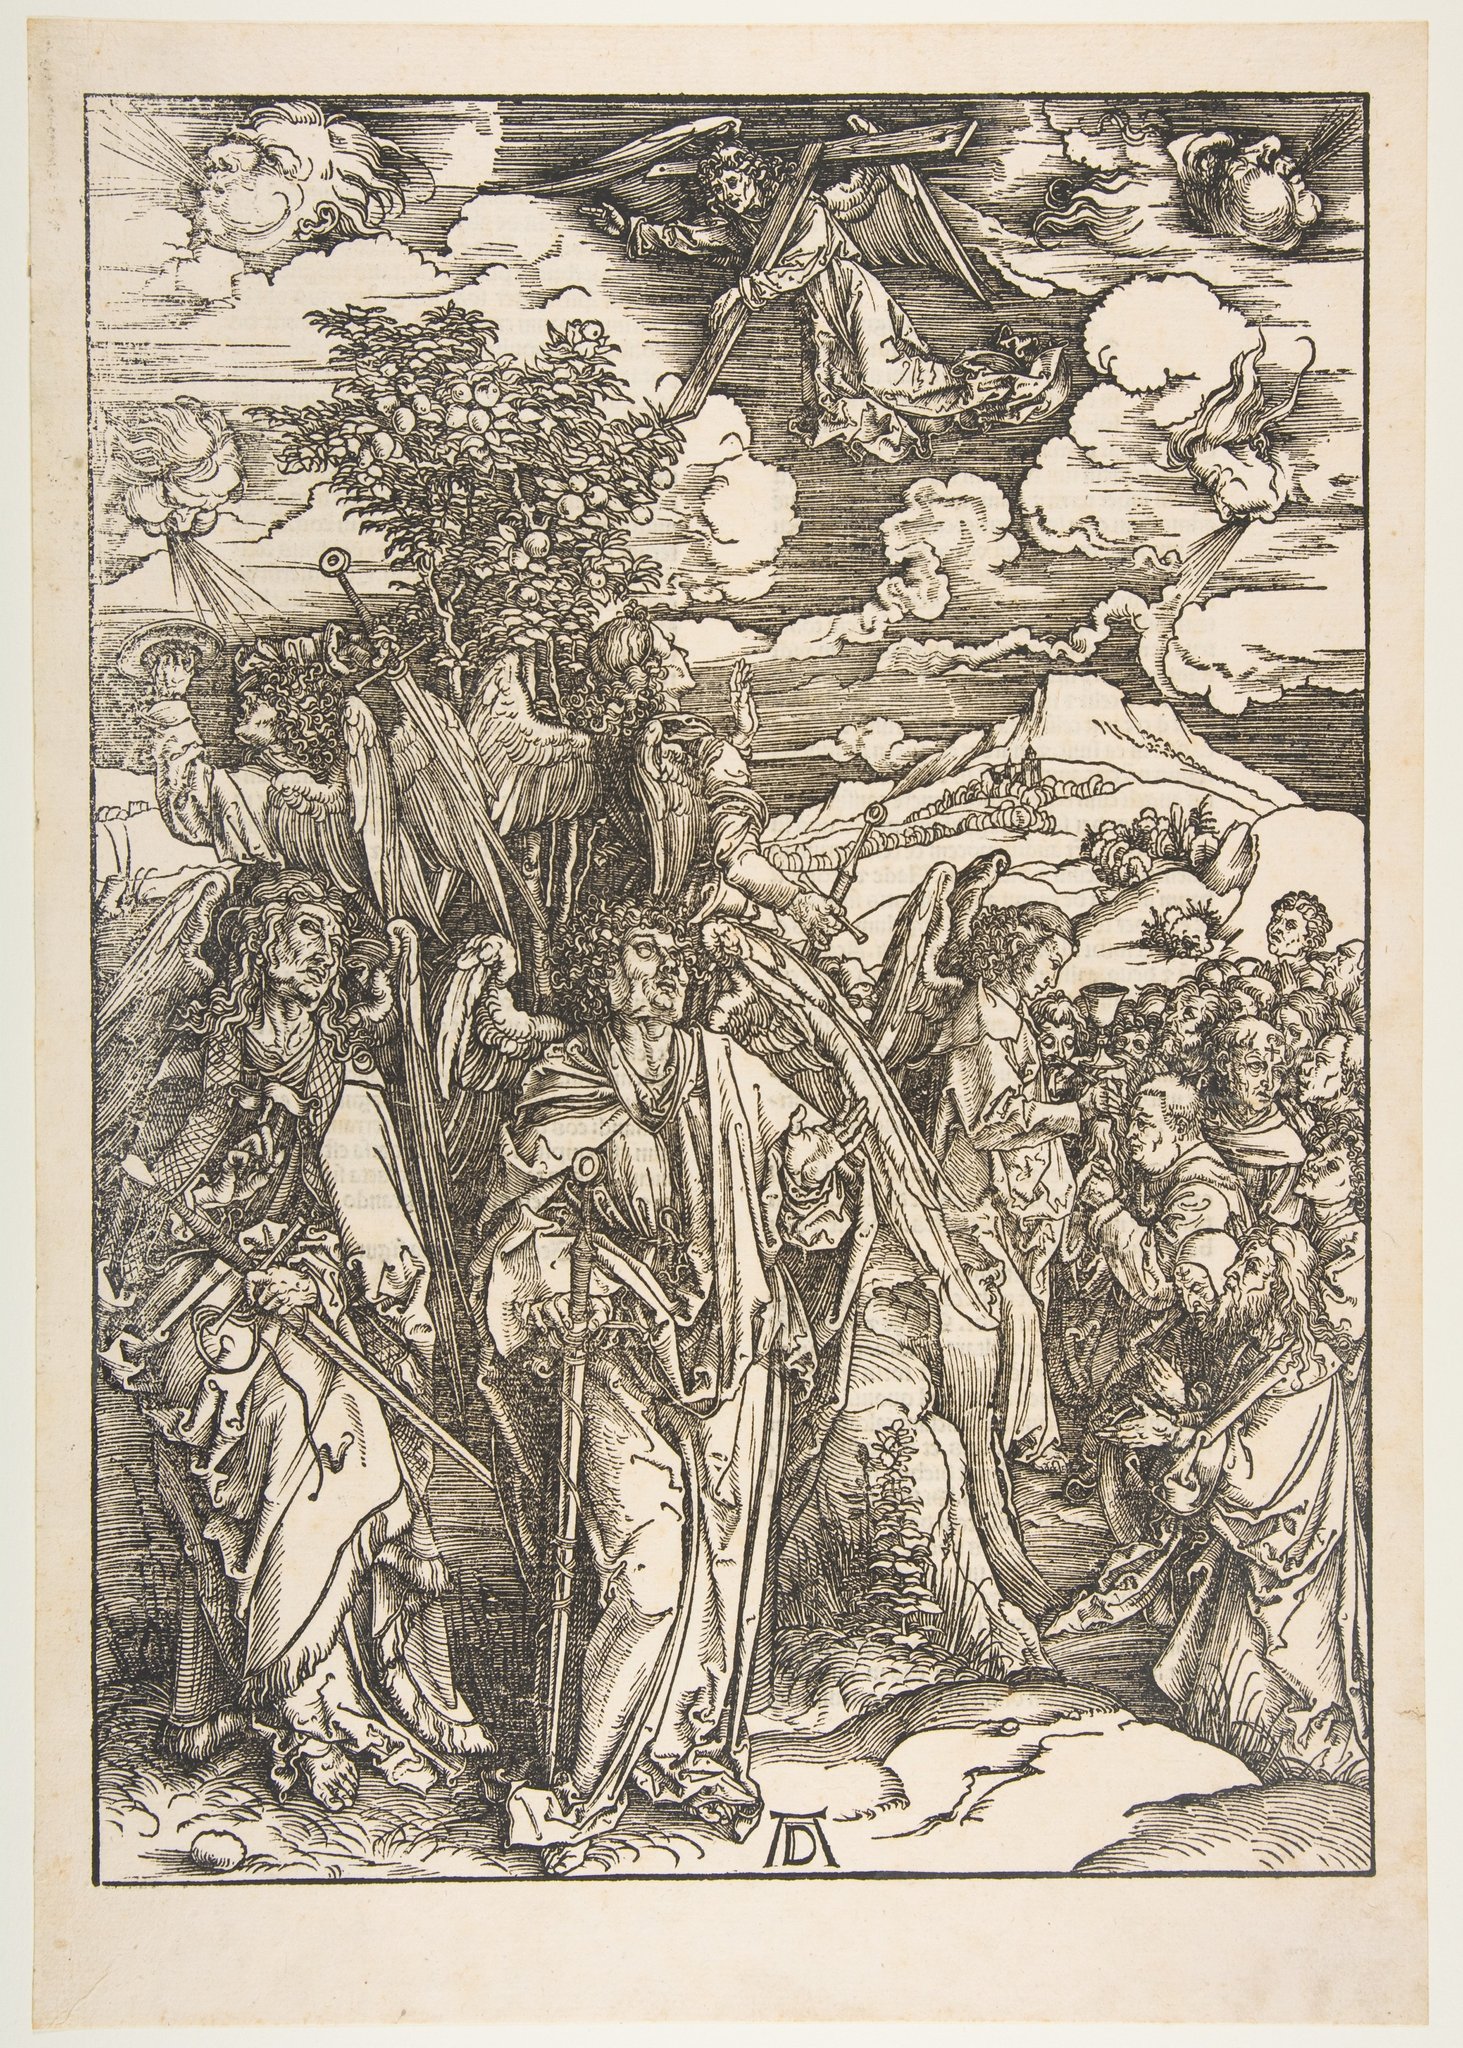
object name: print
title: The Four Angels Holding the Winds, from "The Apocalypse"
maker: albrecht dürer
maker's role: artist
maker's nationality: german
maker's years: 1471-1528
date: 1498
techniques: woodcut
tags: angels,apocalypse